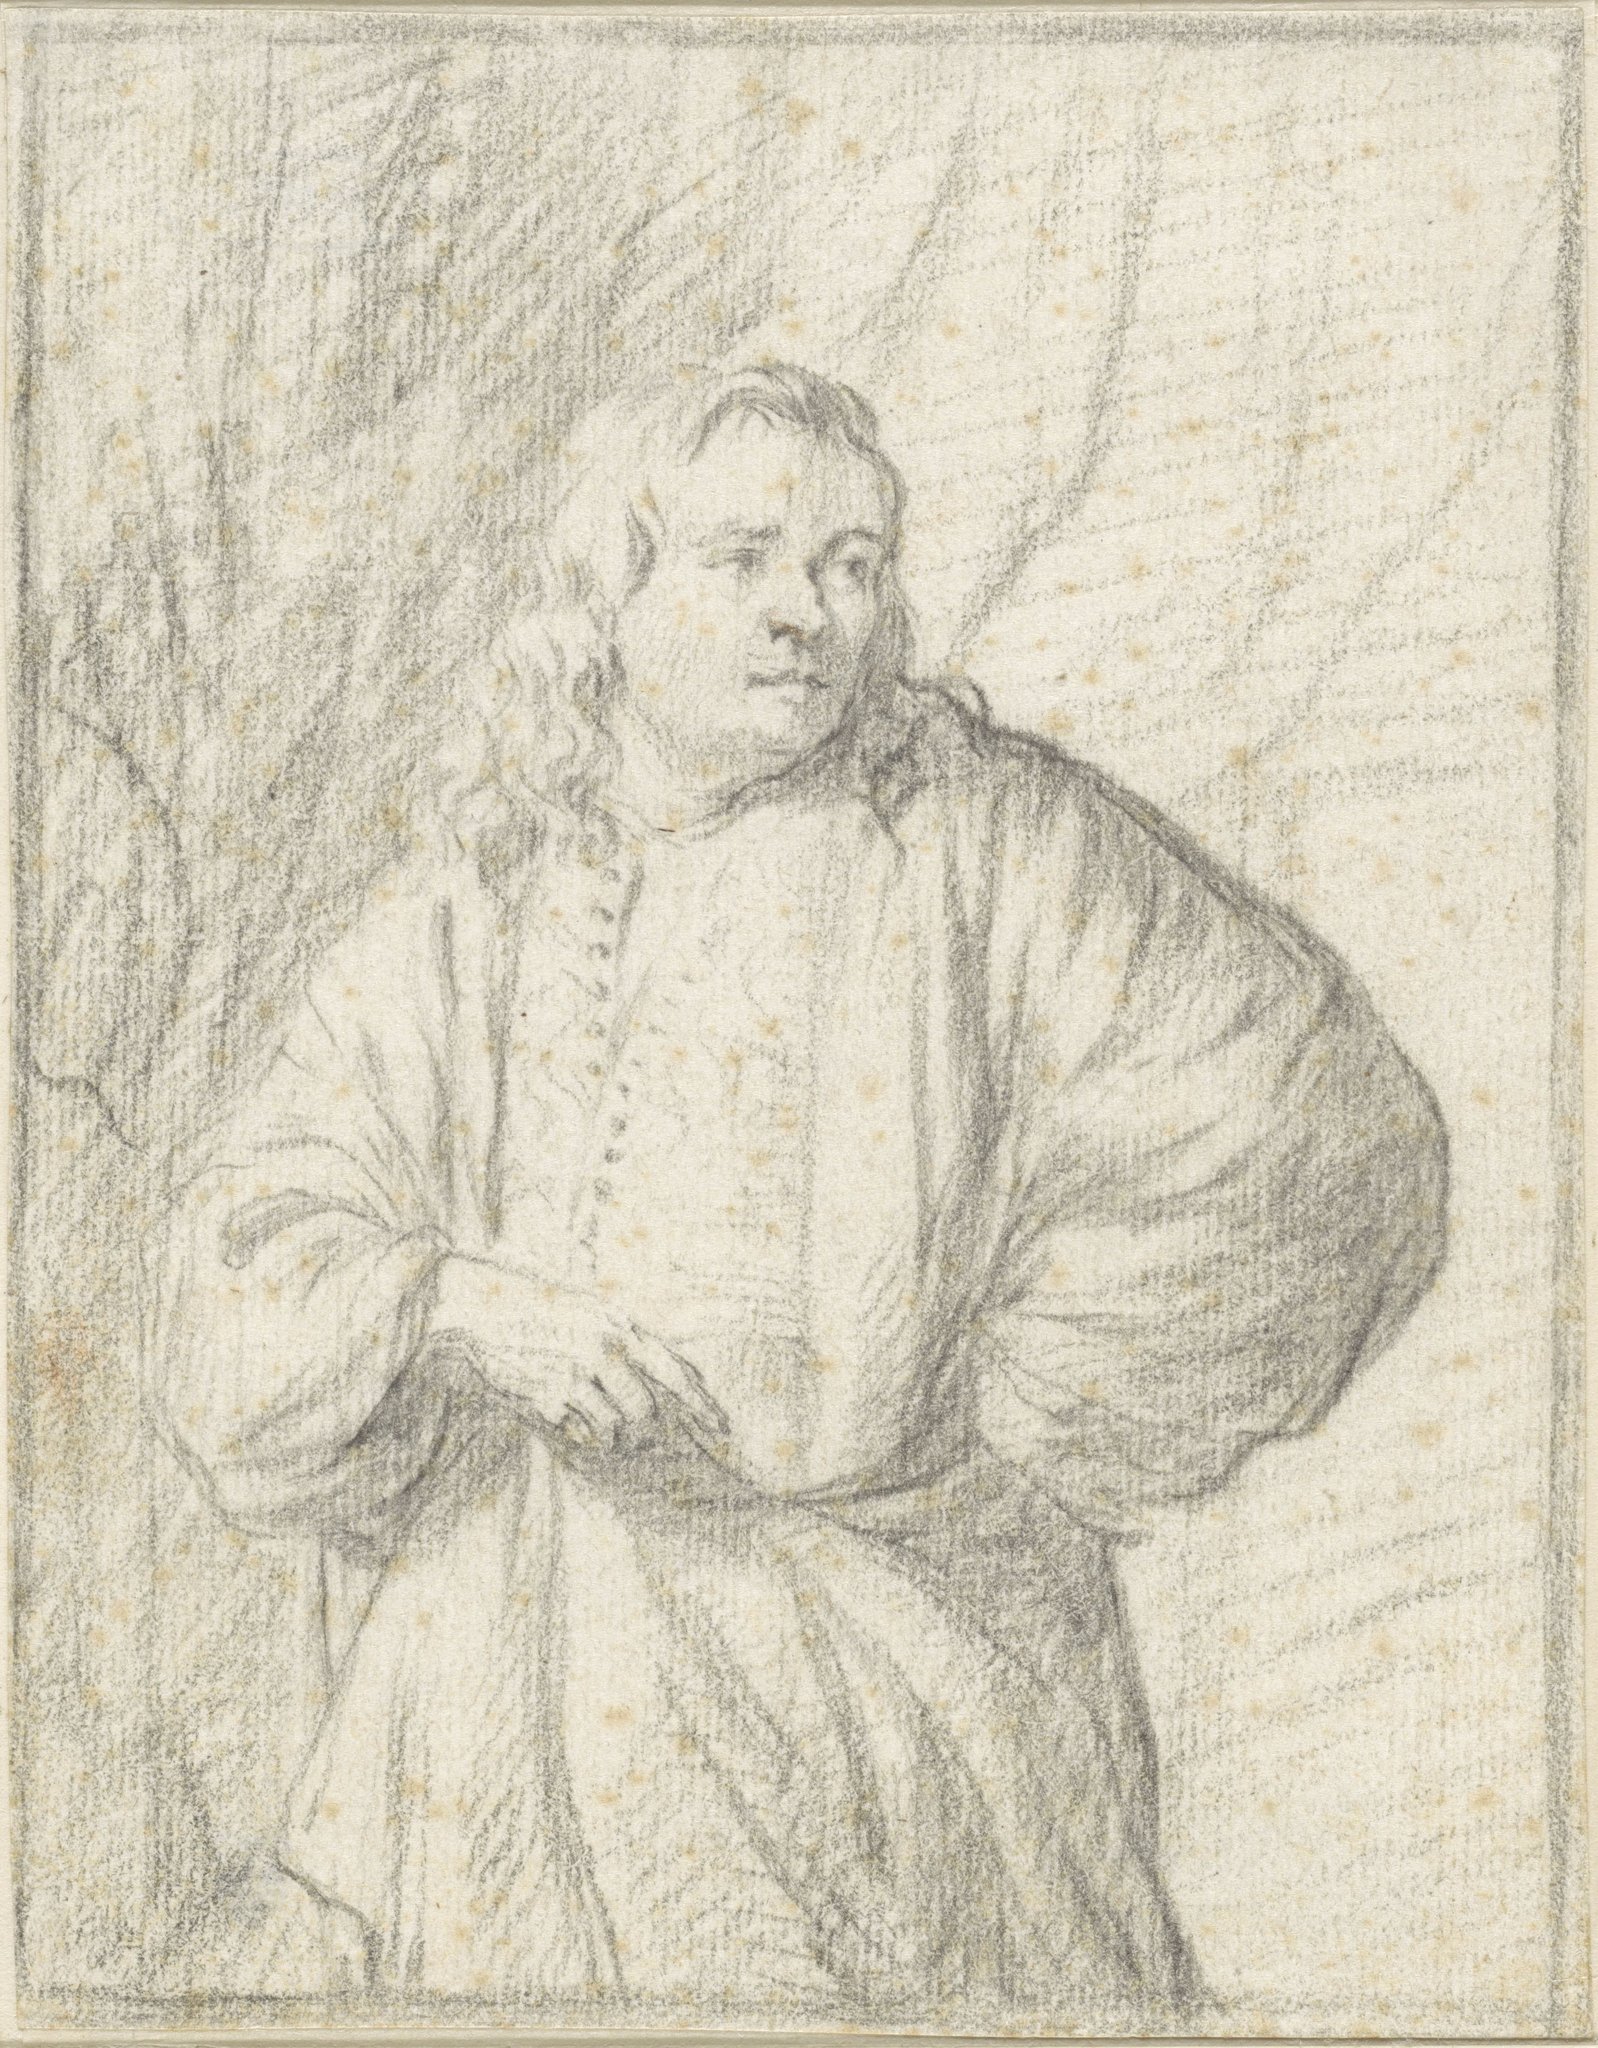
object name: drawing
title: Portret van Pieter van Slingeland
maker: Anonymous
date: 1650-1741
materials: chalk, paper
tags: leiden, painter, print maker, draughtsman, pieter cornelisz. van slingelandt, historical persons, portrait, self-portrait of painter, portrait, self-portrait of artist